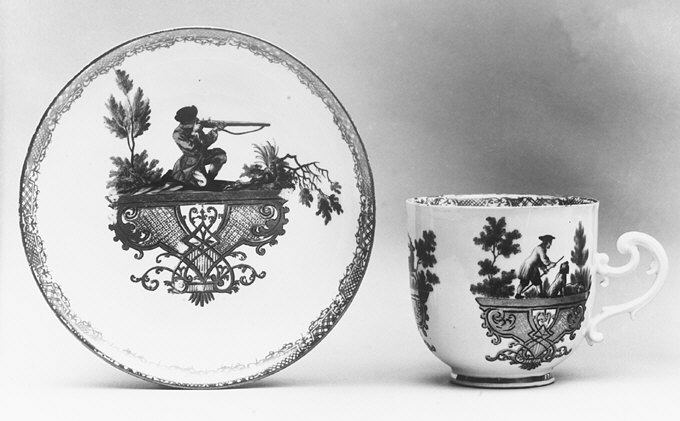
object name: cup and saucer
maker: meissen manufactory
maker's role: manufactory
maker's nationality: german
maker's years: 1710-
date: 1740-1750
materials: hard paste porcelain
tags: human figures,firearms